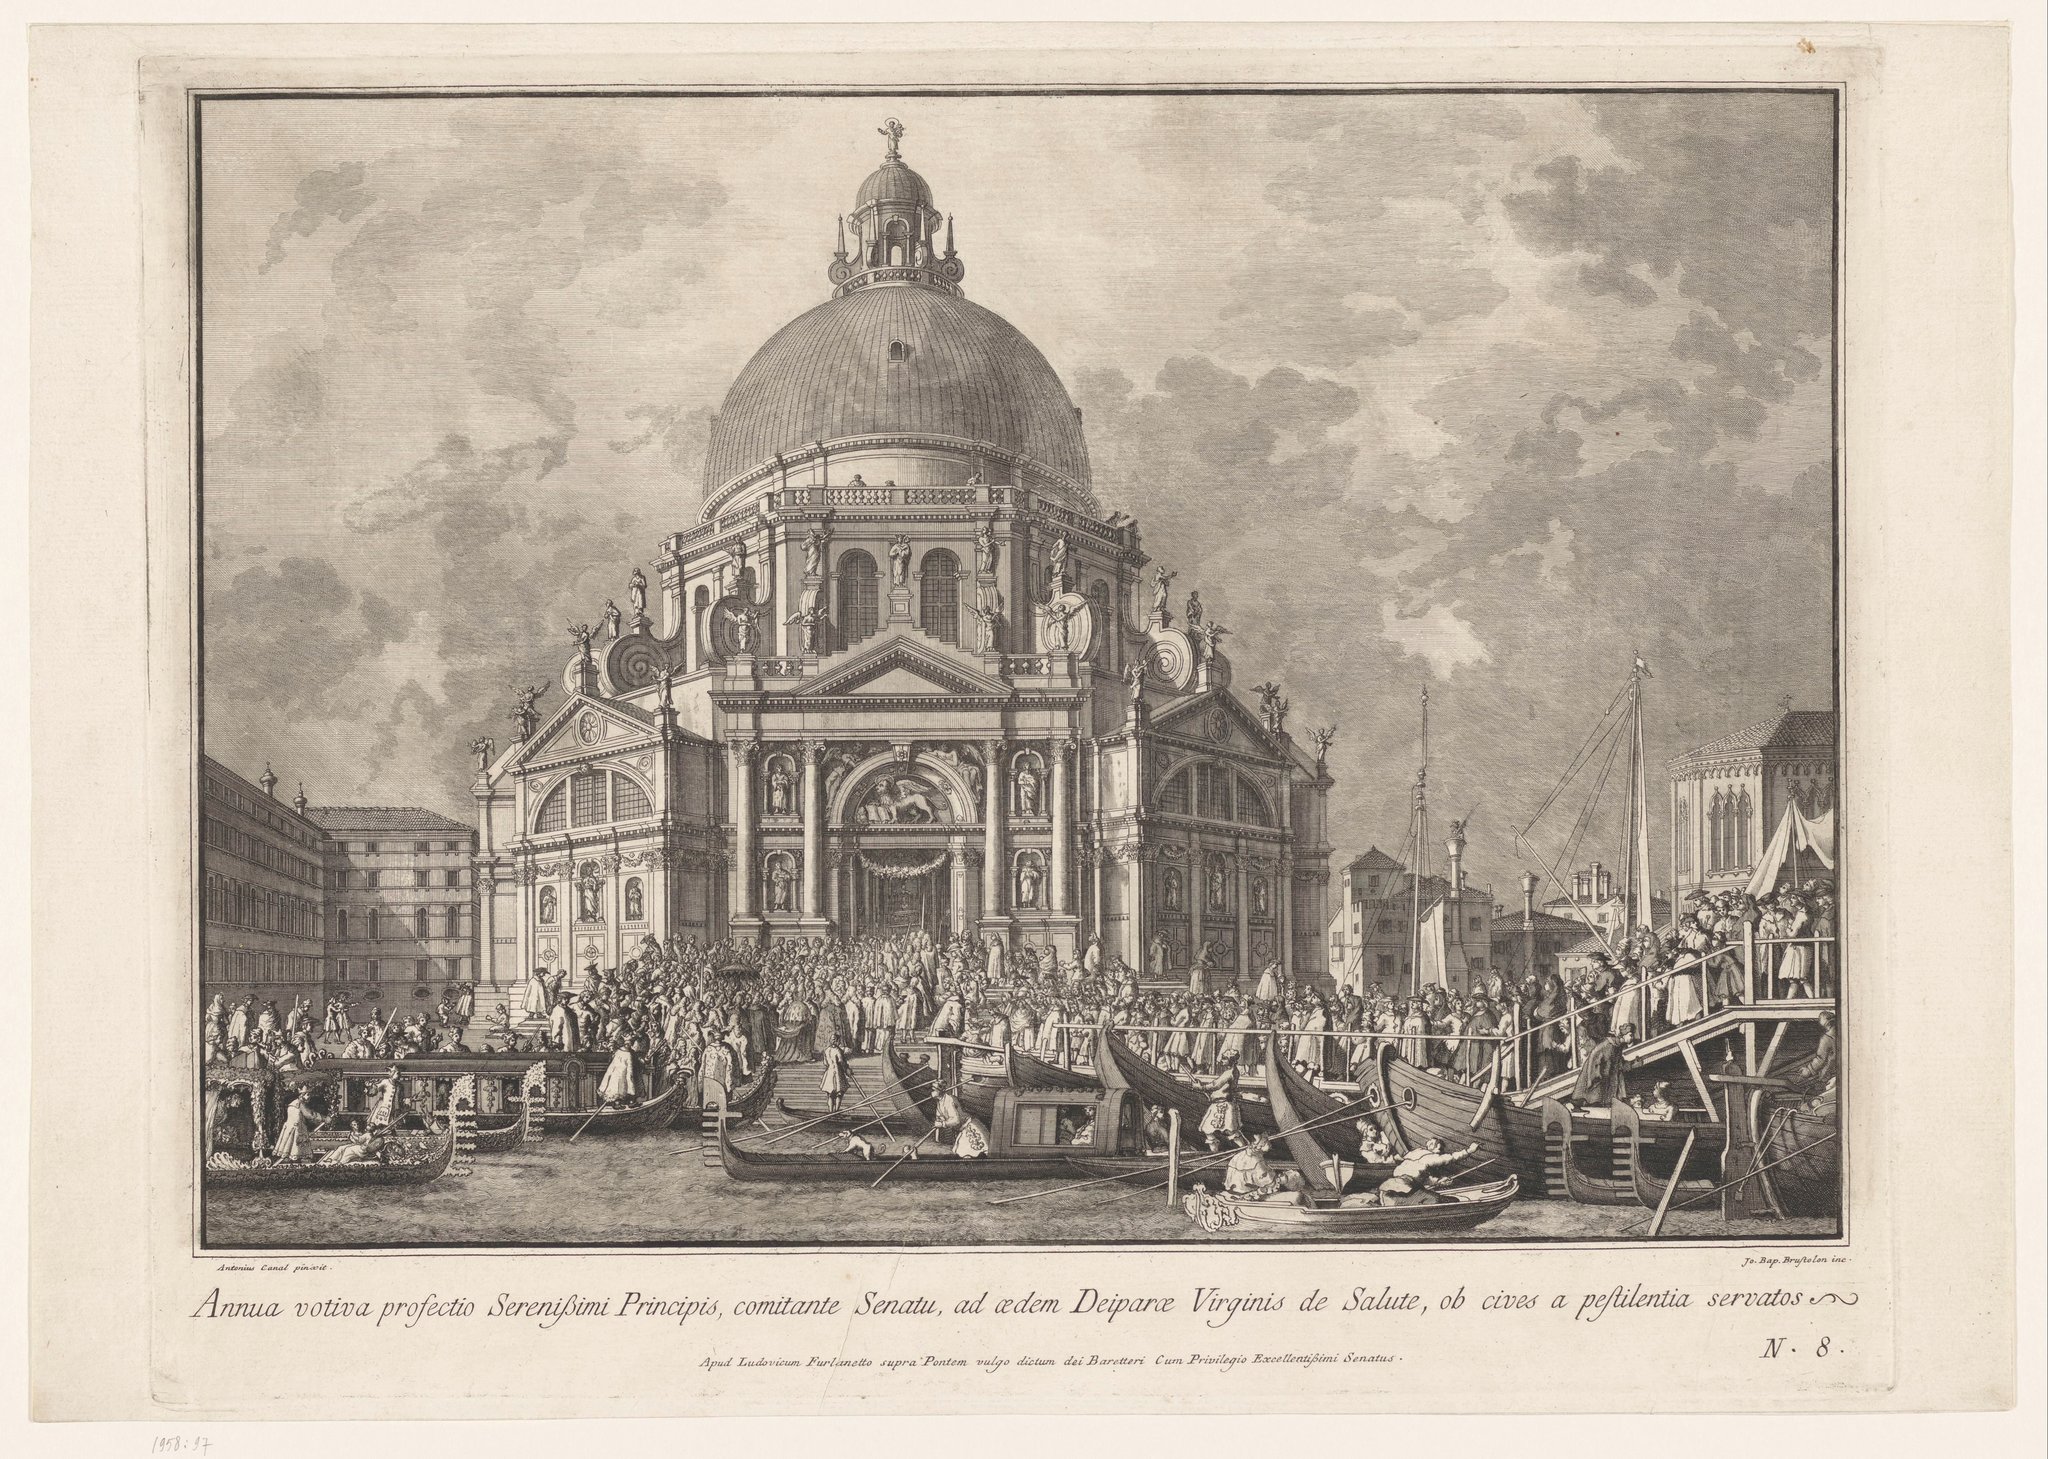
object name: print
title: Solennità dogali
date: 1766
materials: paper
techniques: etching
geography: venice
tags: church (exterior), public festivities, gondola, venice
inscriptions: collector's mark: Lugt 2760, collector's mark: Lugt 2228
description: Een menigte op het portaal en op gondels voor de Santa Maria della Salute aan het Canal Grande te Venetië. Genummerd rechtsonder: No. 8.